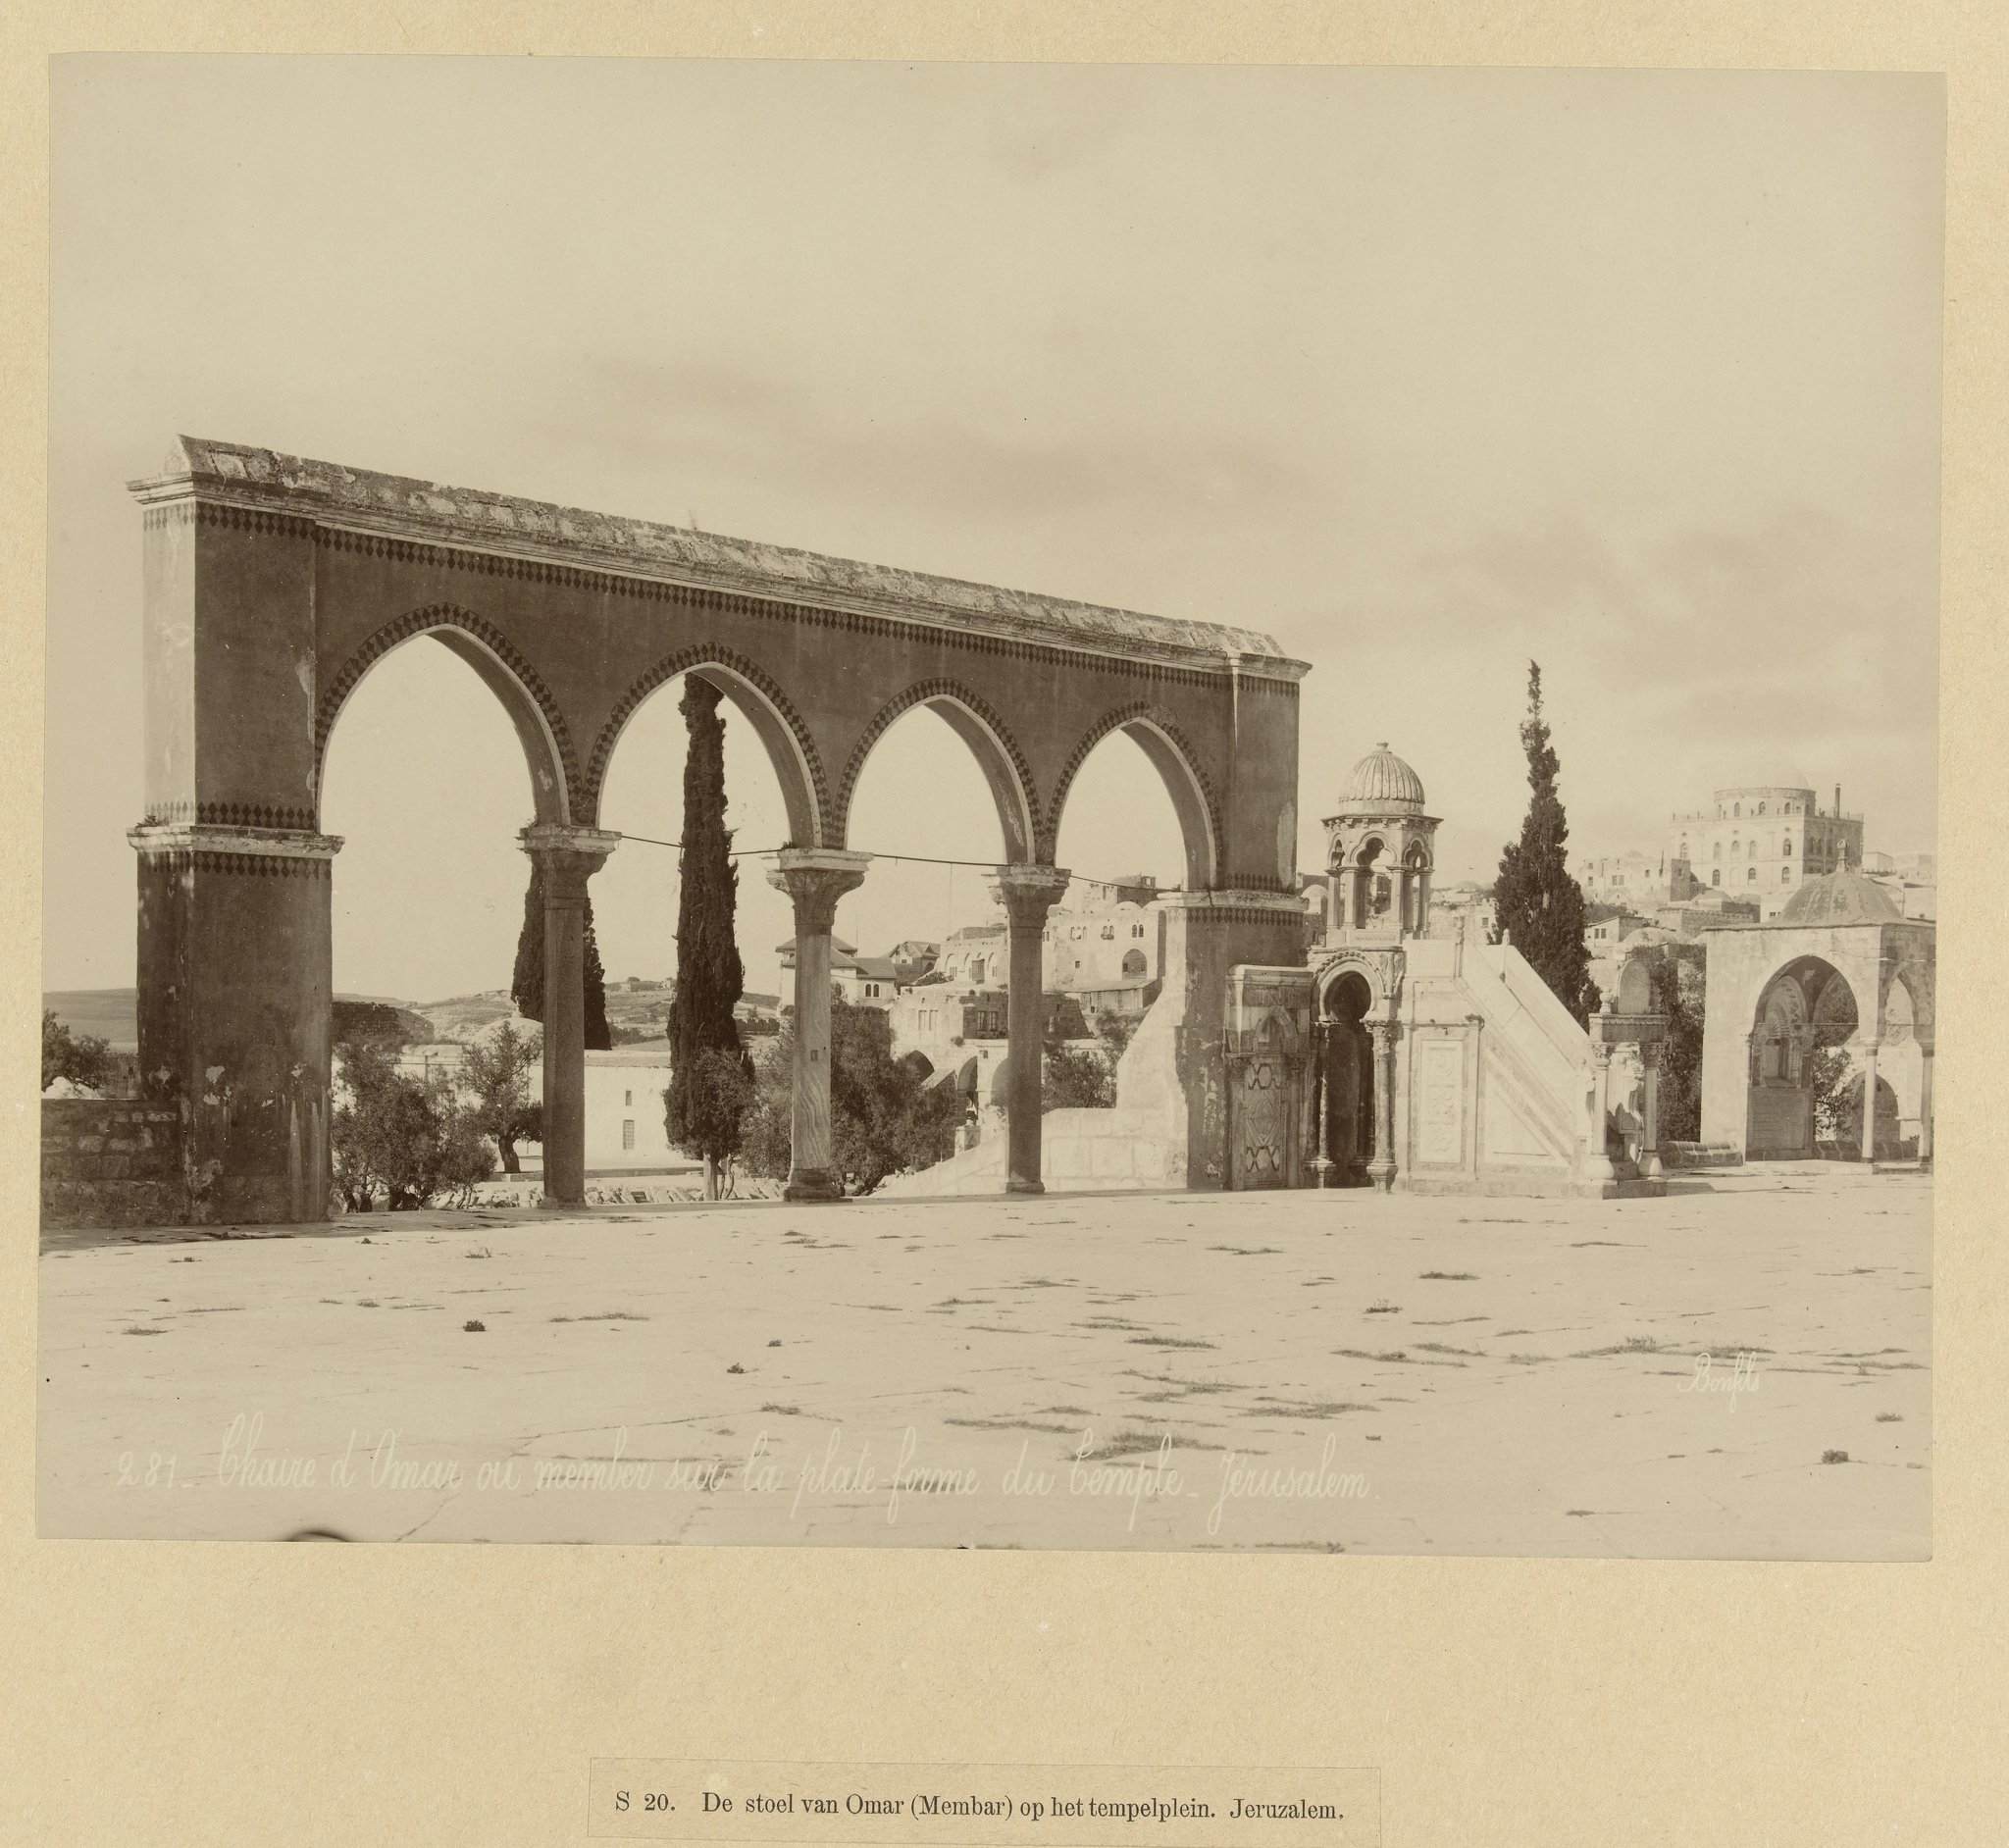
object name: photograph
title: Chaire d'Omar ou member sur la plate-forme du Temple - Jérusalem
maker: félix bonfils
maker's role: fotograaf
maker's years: 1831-1885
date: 1867-1877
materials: cardboard, paper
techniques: albumen print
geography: jerusalem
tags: arch, archivolt ~ architecture, temple, shrine ~ islam, mohammedanism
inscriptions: title: ‘S 20. De stoel van Omar (Membar) op het tempelplein. Jeruzalem.’, number: ‘281’, stamp: ‘Gemeentelijke bibliotheek/ Rotterdam’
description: Onderdeel van een groep door fotograaf Richard Polak op reis verzamelde foto’s. Deze foto is samen met andere op zijn reizen verzamelde foto's tentoongesteld bij de Rotterdamsche Kunstkring (1895), Arti en Amicitiae te Amsterdam (1897-1898?) en Societeit 't Collegie te Kampen (datum vooralsnog onbekend).